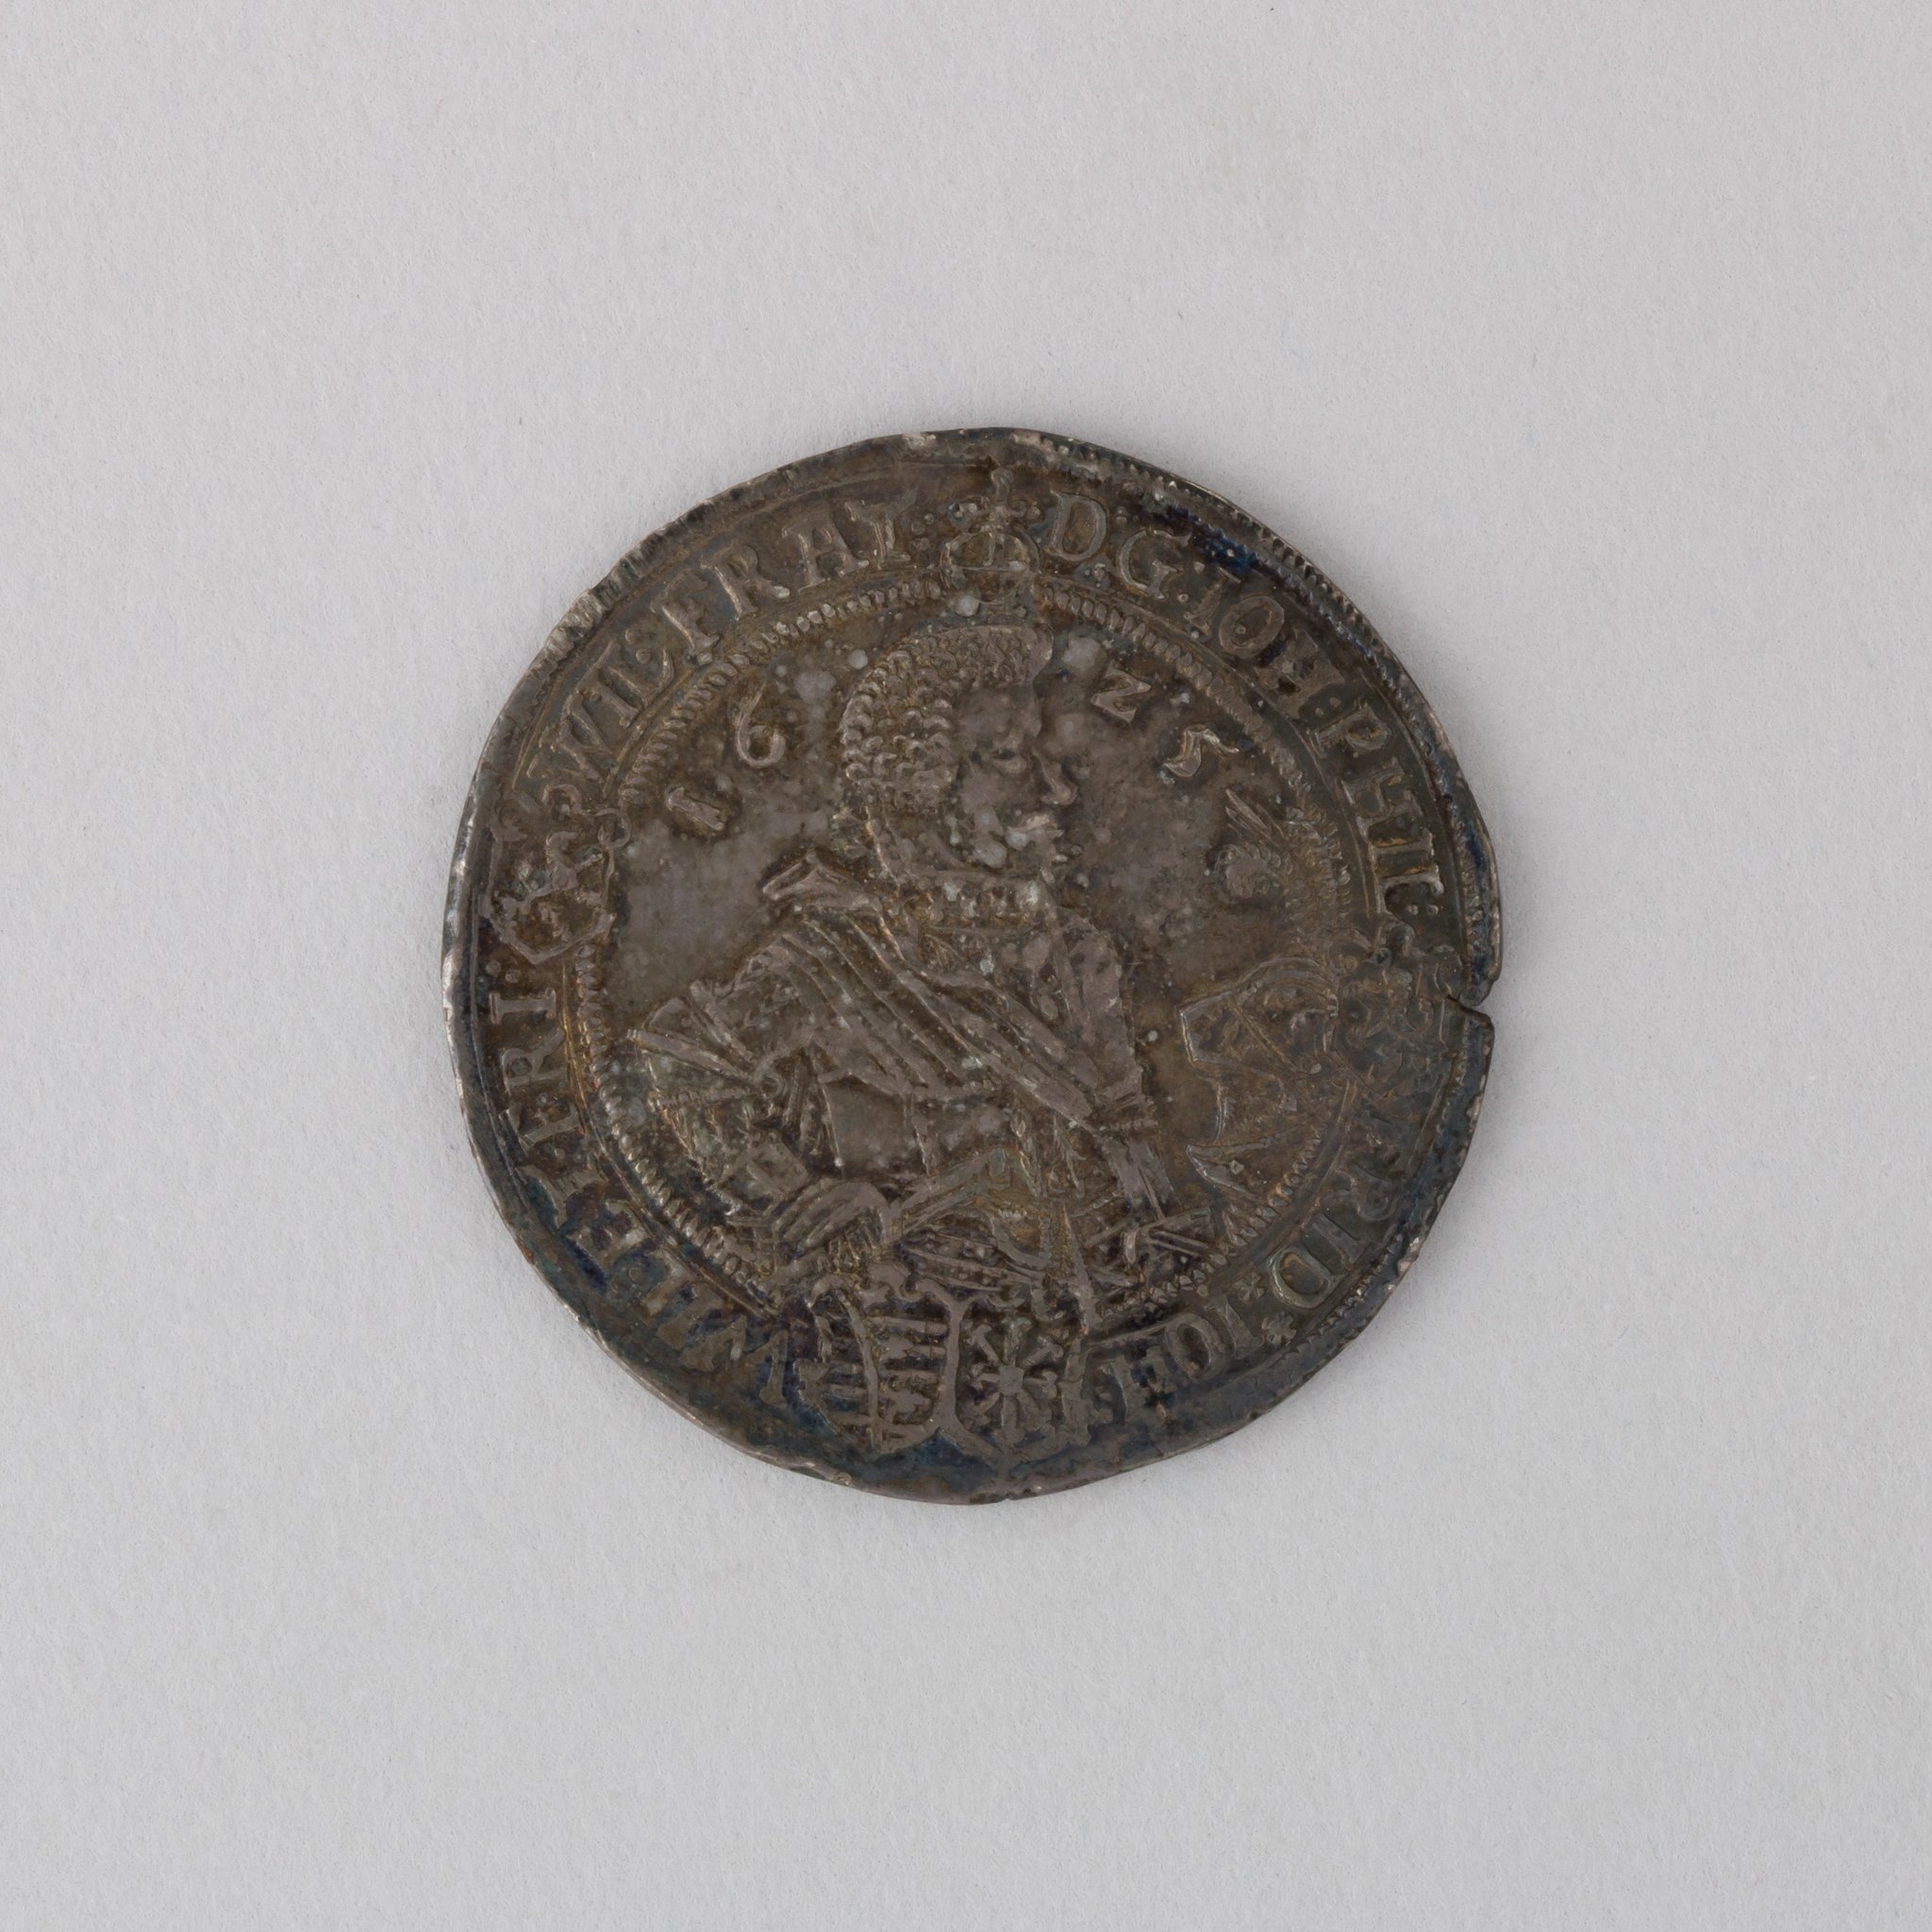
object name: coin thaler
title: Coin (Thaler) Showing John Philip, Duke of Saxony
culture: german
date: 1625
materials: silver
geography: germany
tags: men